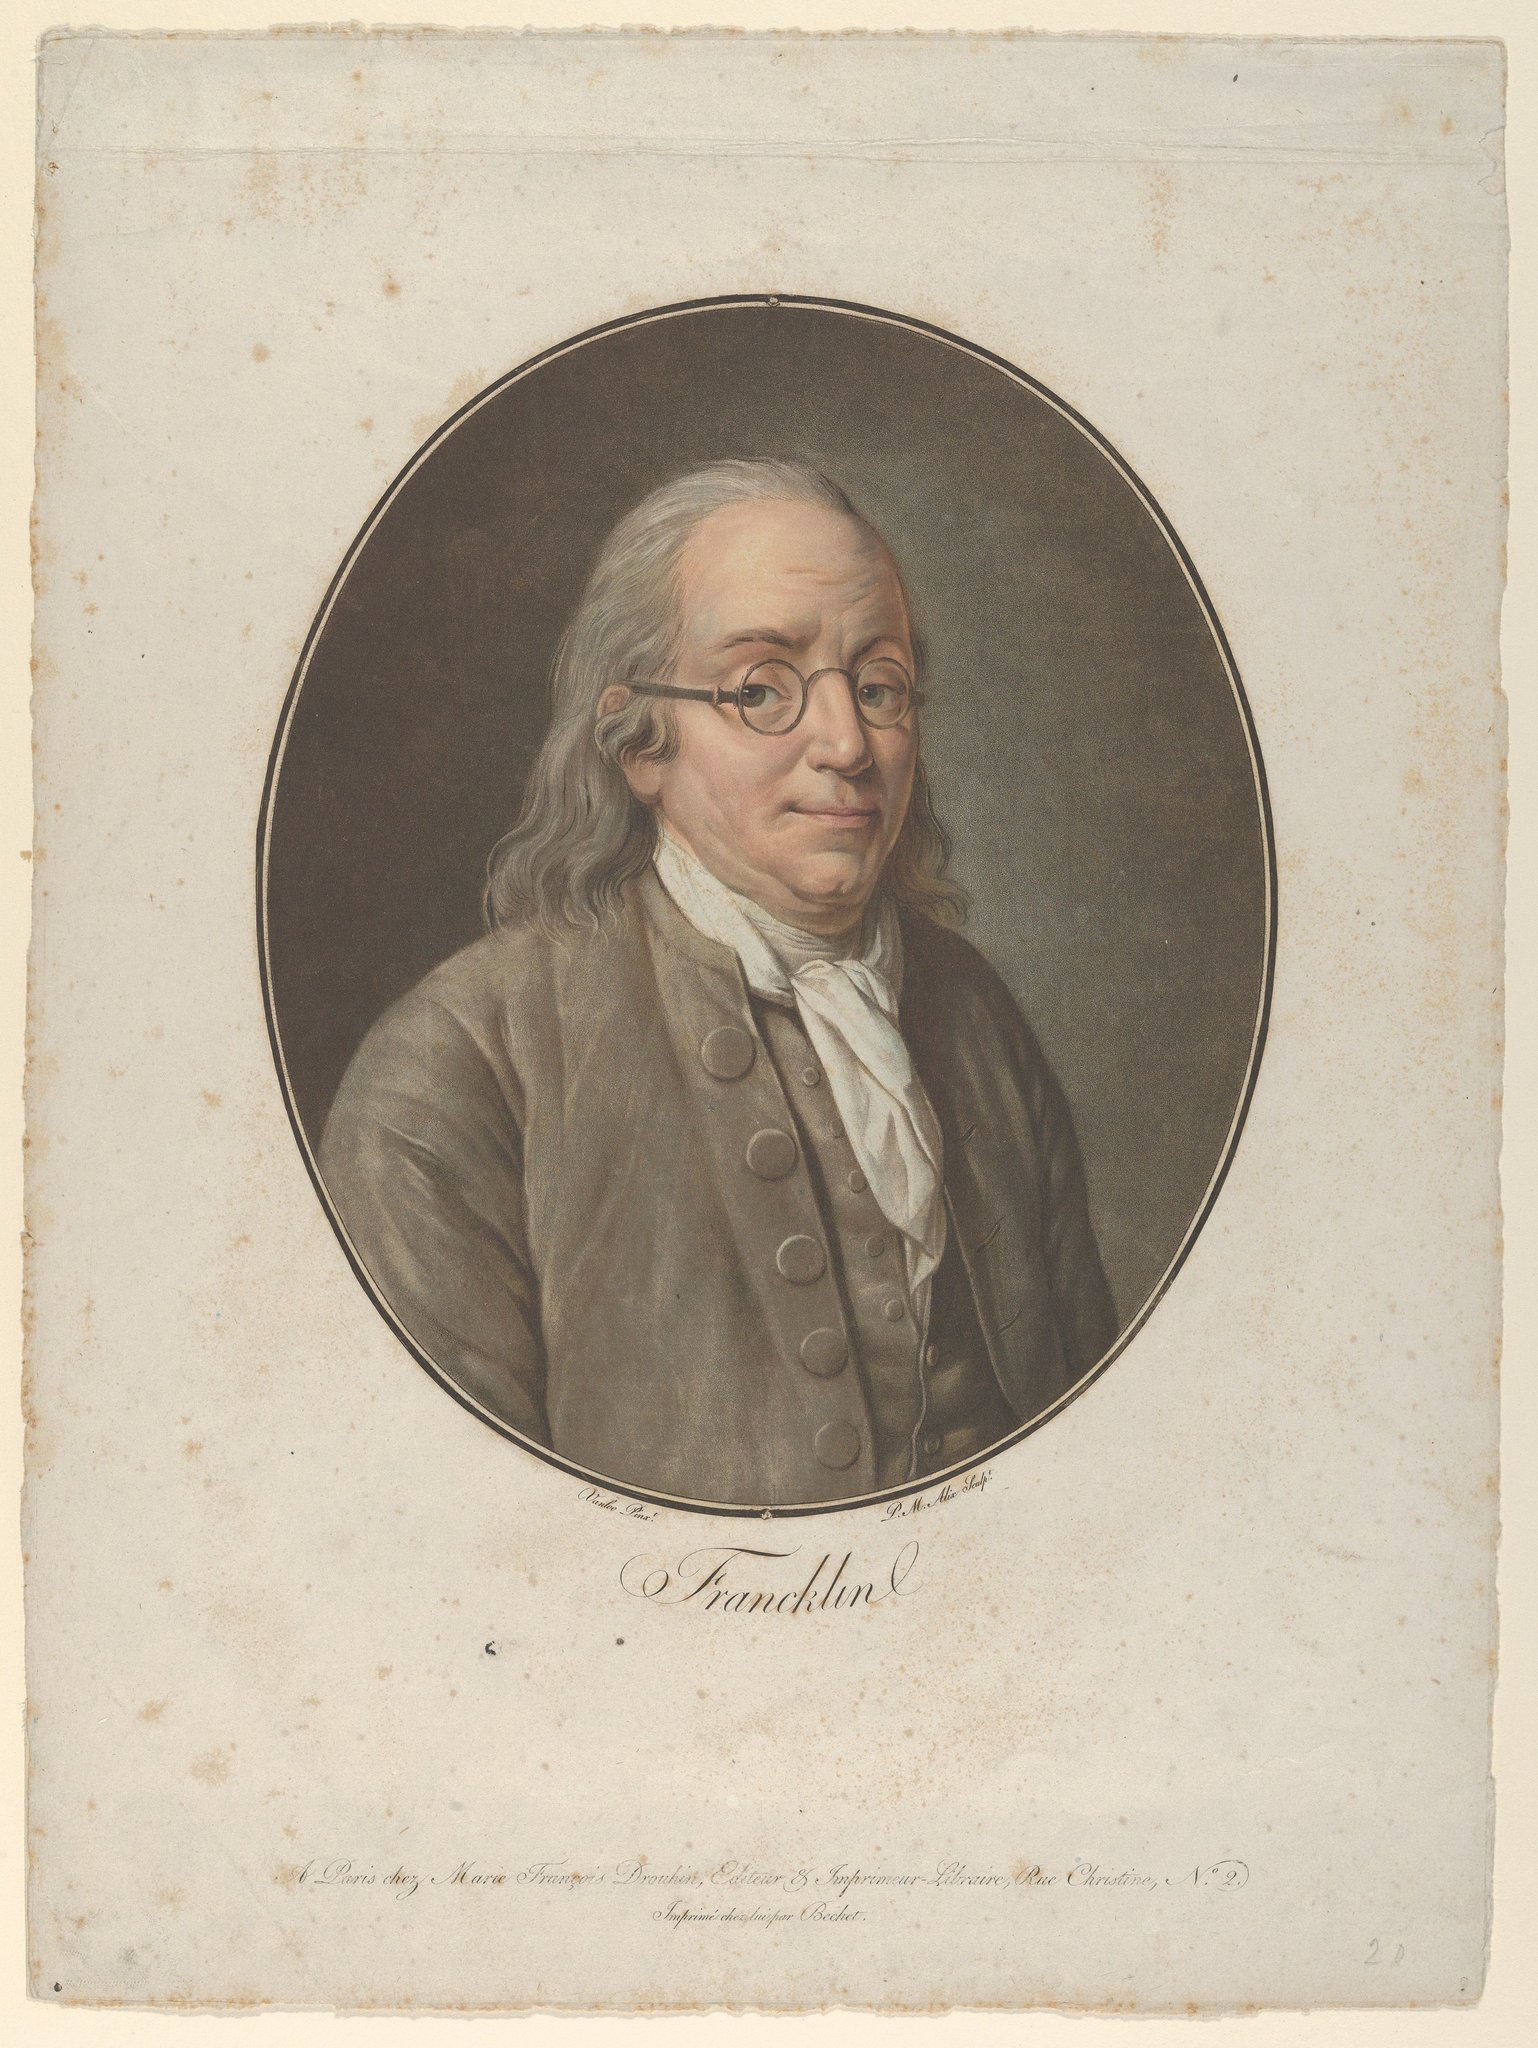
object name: print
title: Portrait of Franklin, after Vanloo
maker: pierre michel alix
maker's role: artist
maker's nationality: french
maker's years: 1762-1817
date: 1795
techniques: aquatint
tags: benjamin franklin,portraits